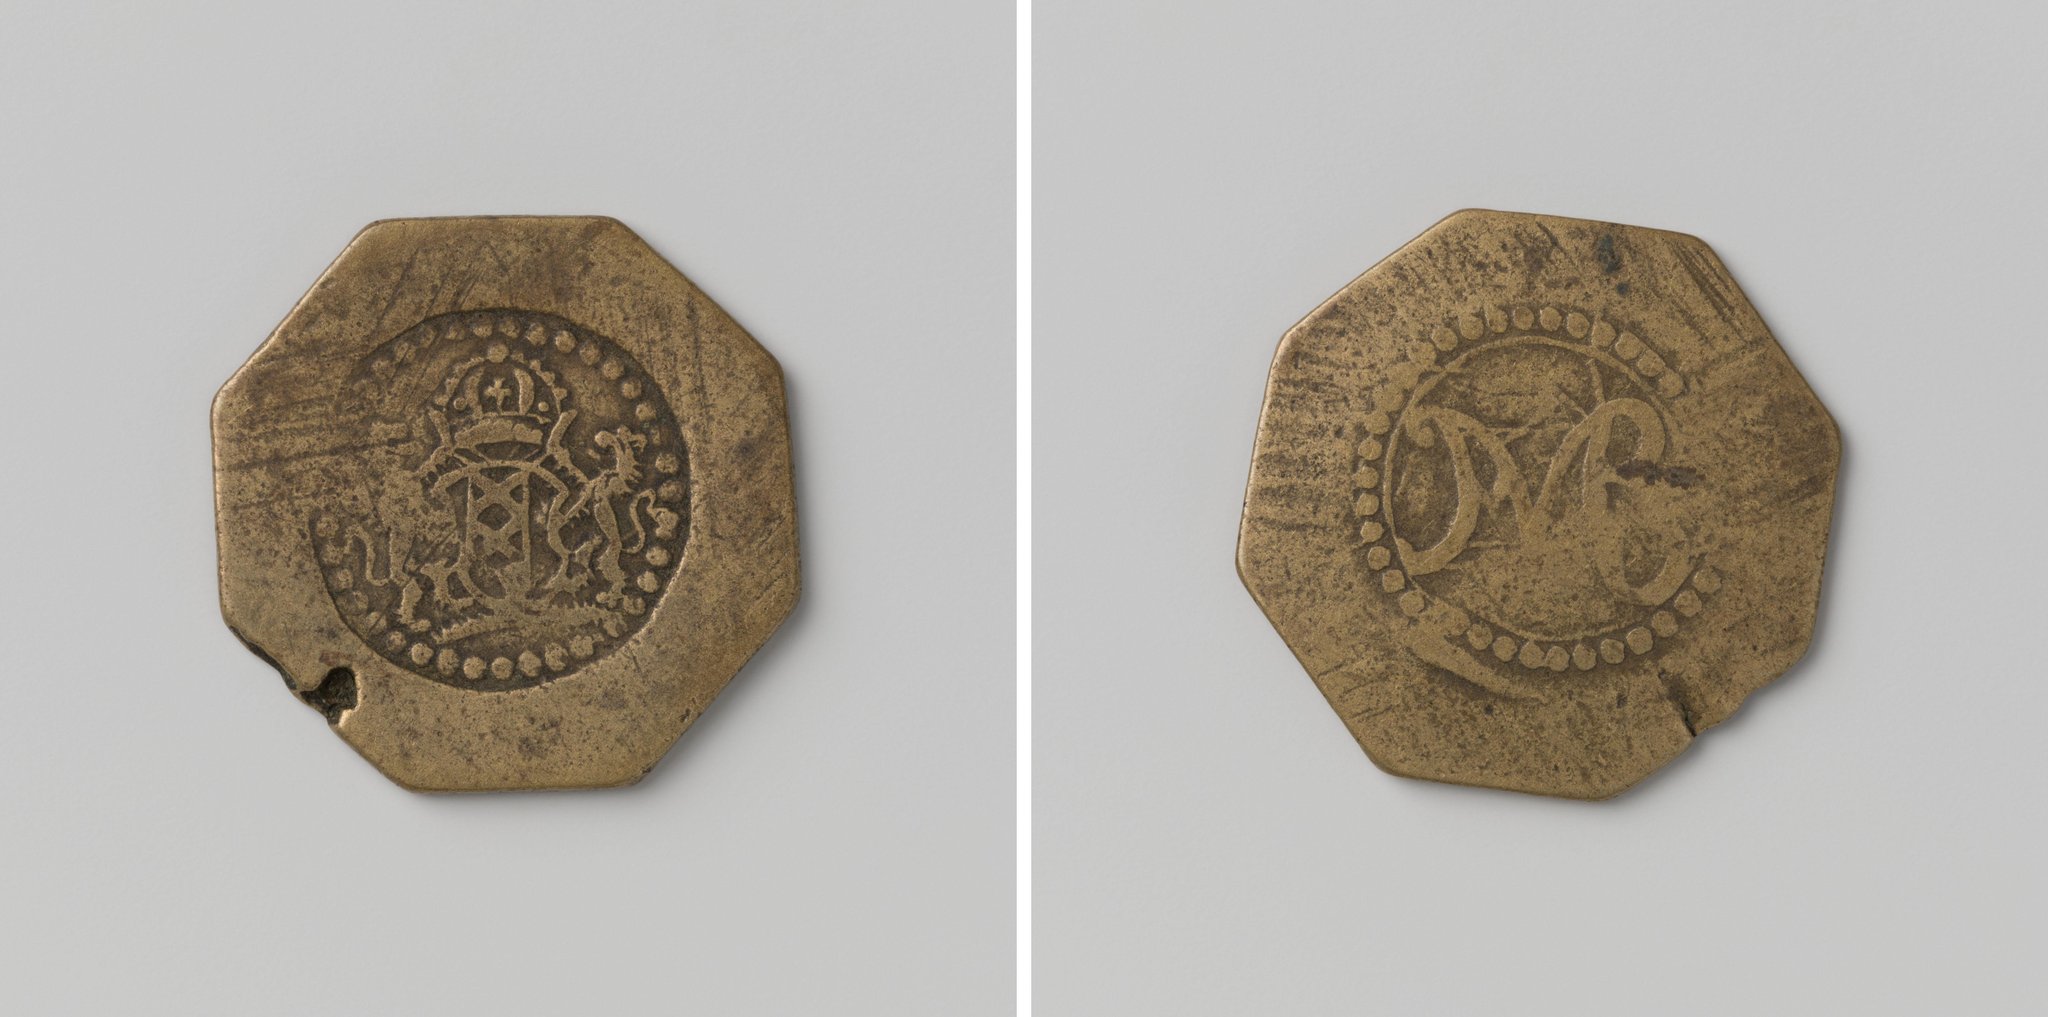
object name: medal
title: Makelaarsgilde van Amsterdam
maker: Anonymous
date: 1600-1800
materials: brass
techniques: striking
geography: amsterdam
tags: amsterdam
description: Messing achthoekige penning. Voorzijde: in ronde parelcirkel: gekroond wapenschild, geflankeerd door twee leeuwen. Keerzijde: in ronde parelcirkel: monogram van letters M, A, R en S.`